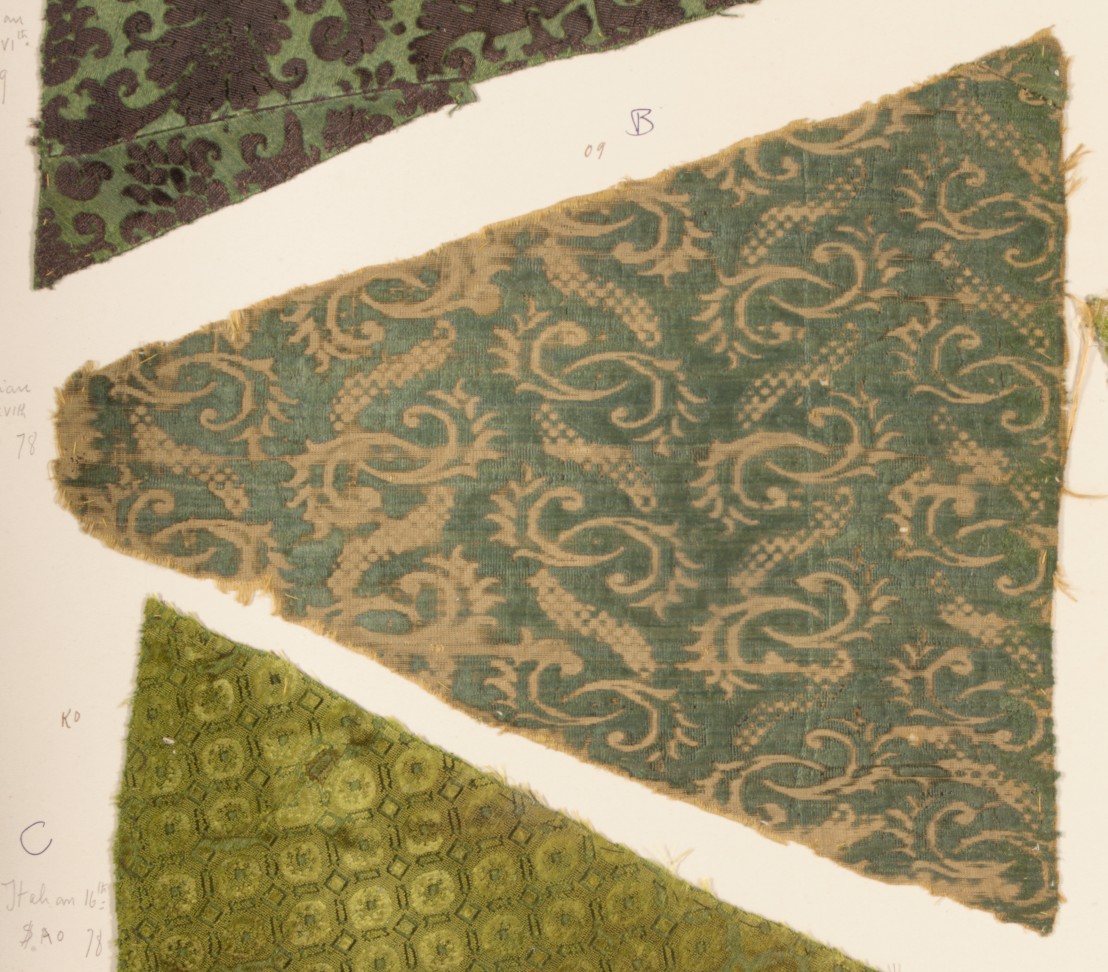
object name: fragment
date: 1567-1600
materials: silk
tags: leaves